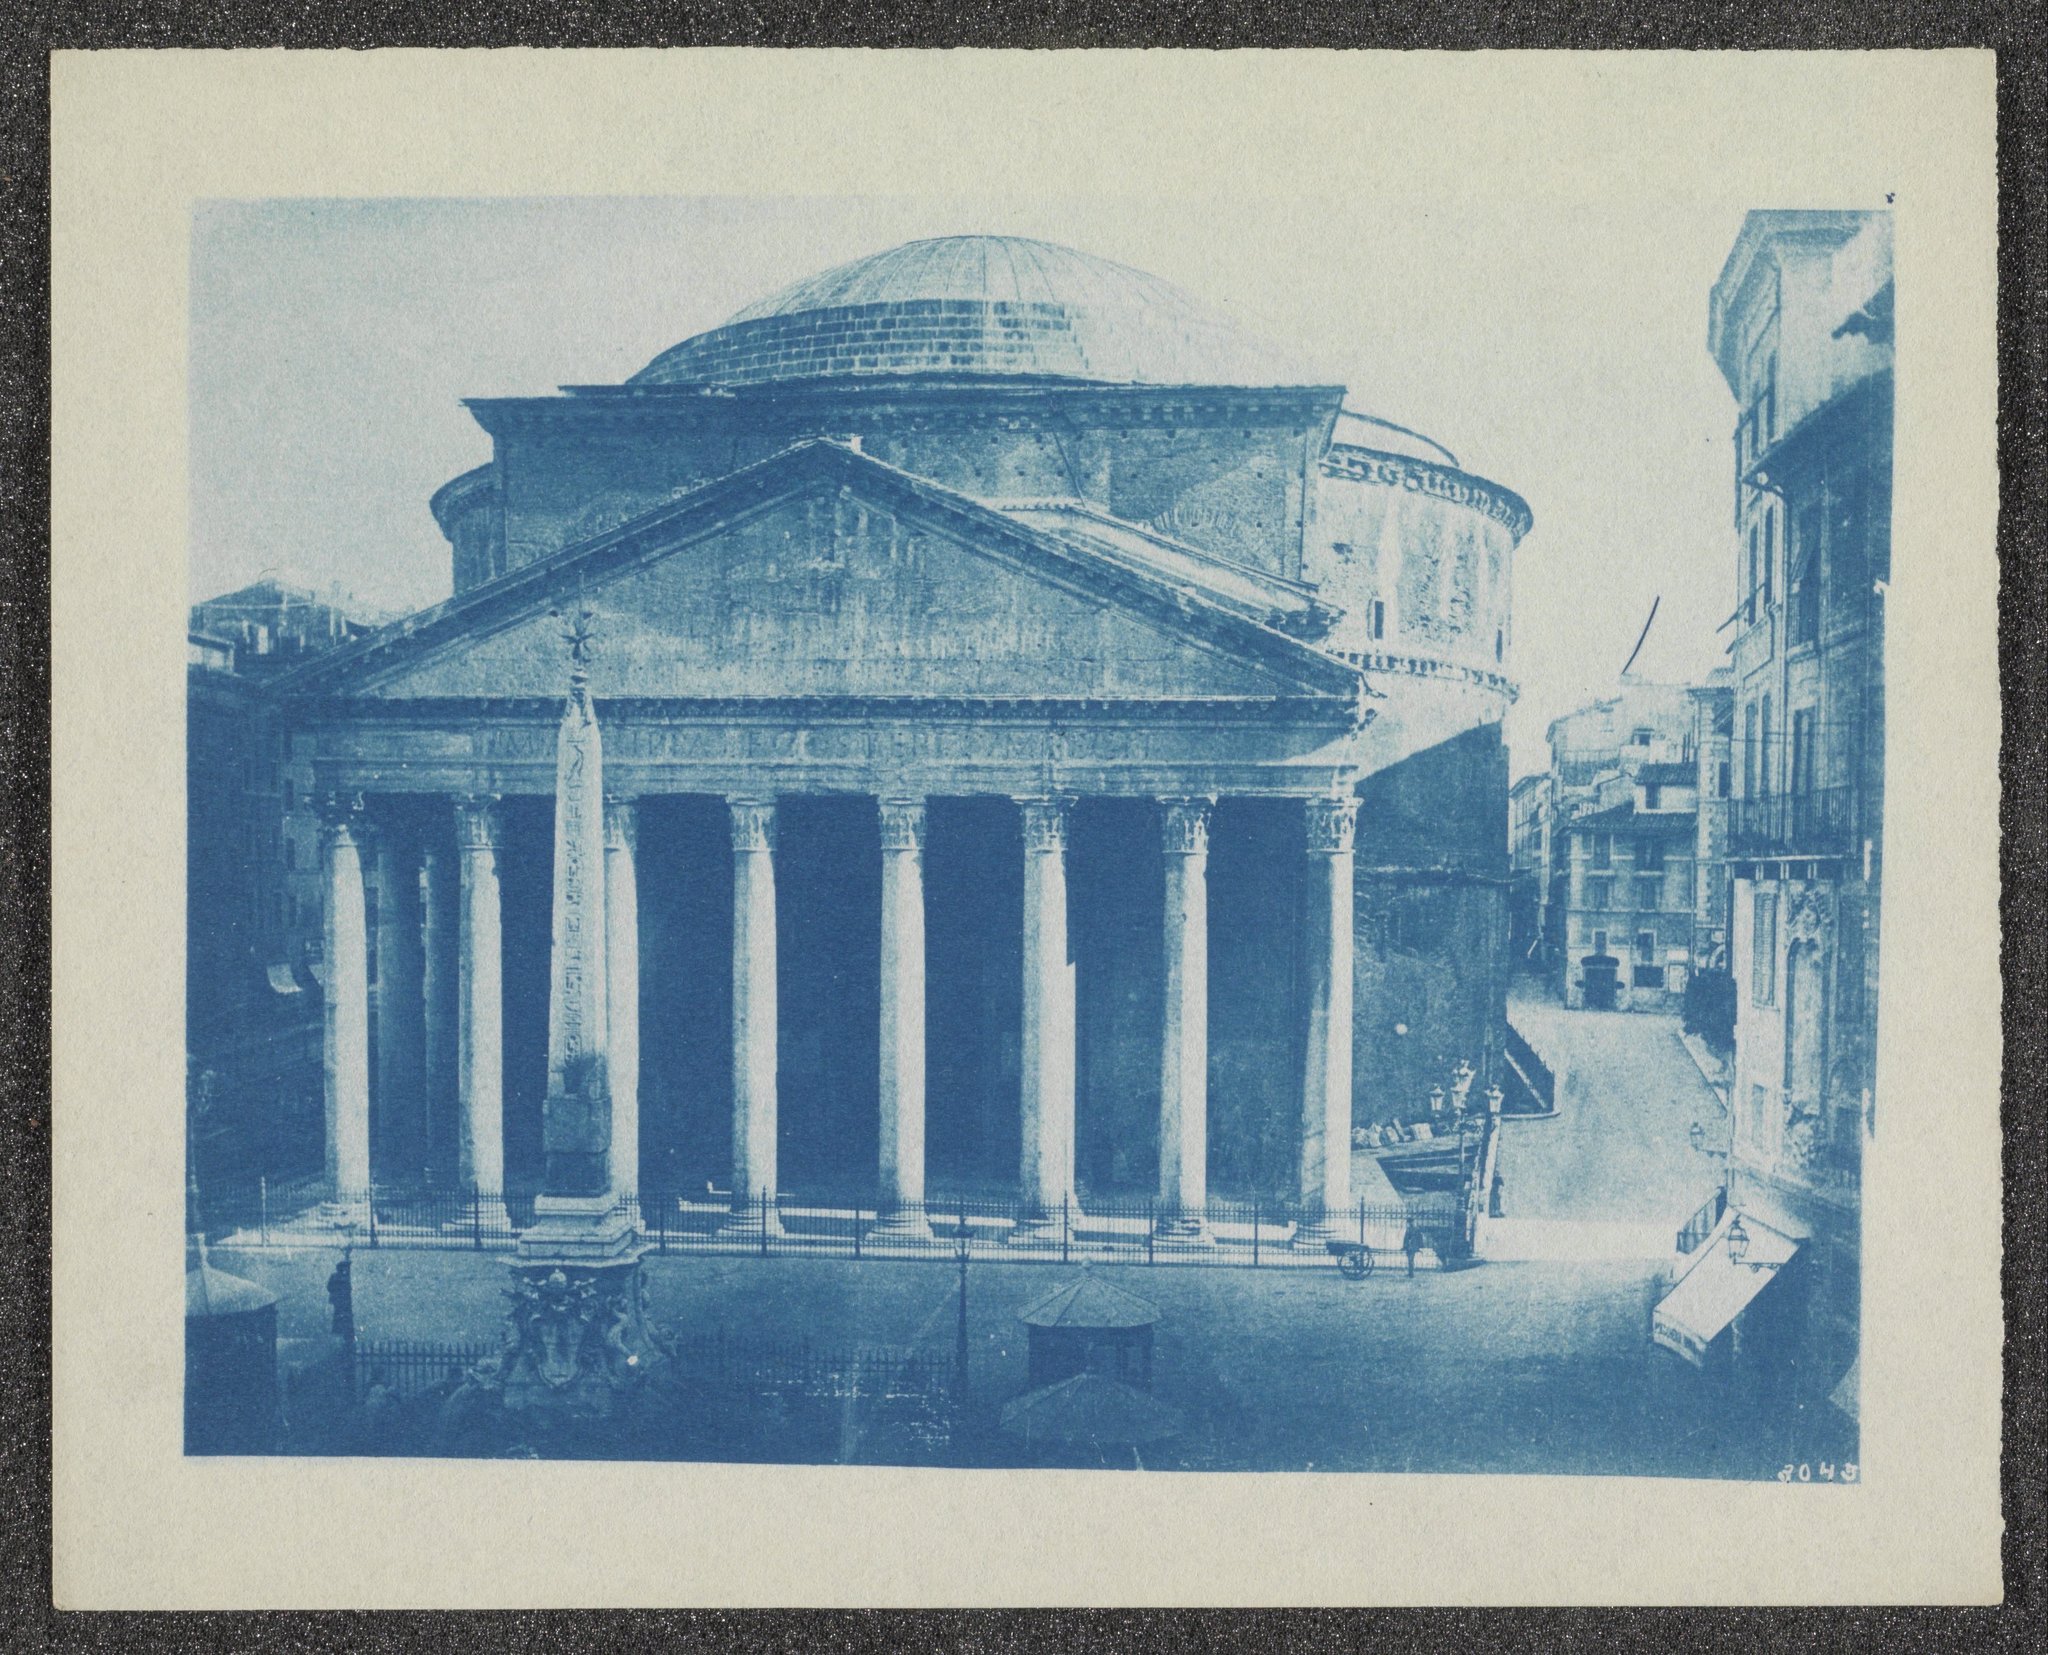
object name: reproduction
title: Fotoreproductie van een foto van het Pantheon te Rome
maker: Anonymous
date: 1880-1905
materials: paper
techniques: cyanotype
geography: rome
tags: obelisk, needle, church (exterior)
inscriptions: number: ‘3043’, inscription: ‘Pantheon - Rome./ King Victor Emmanuel II/ buried here. When/ Roosevelt was last in/ Rome, he placed a/ wrath on the tomb.’